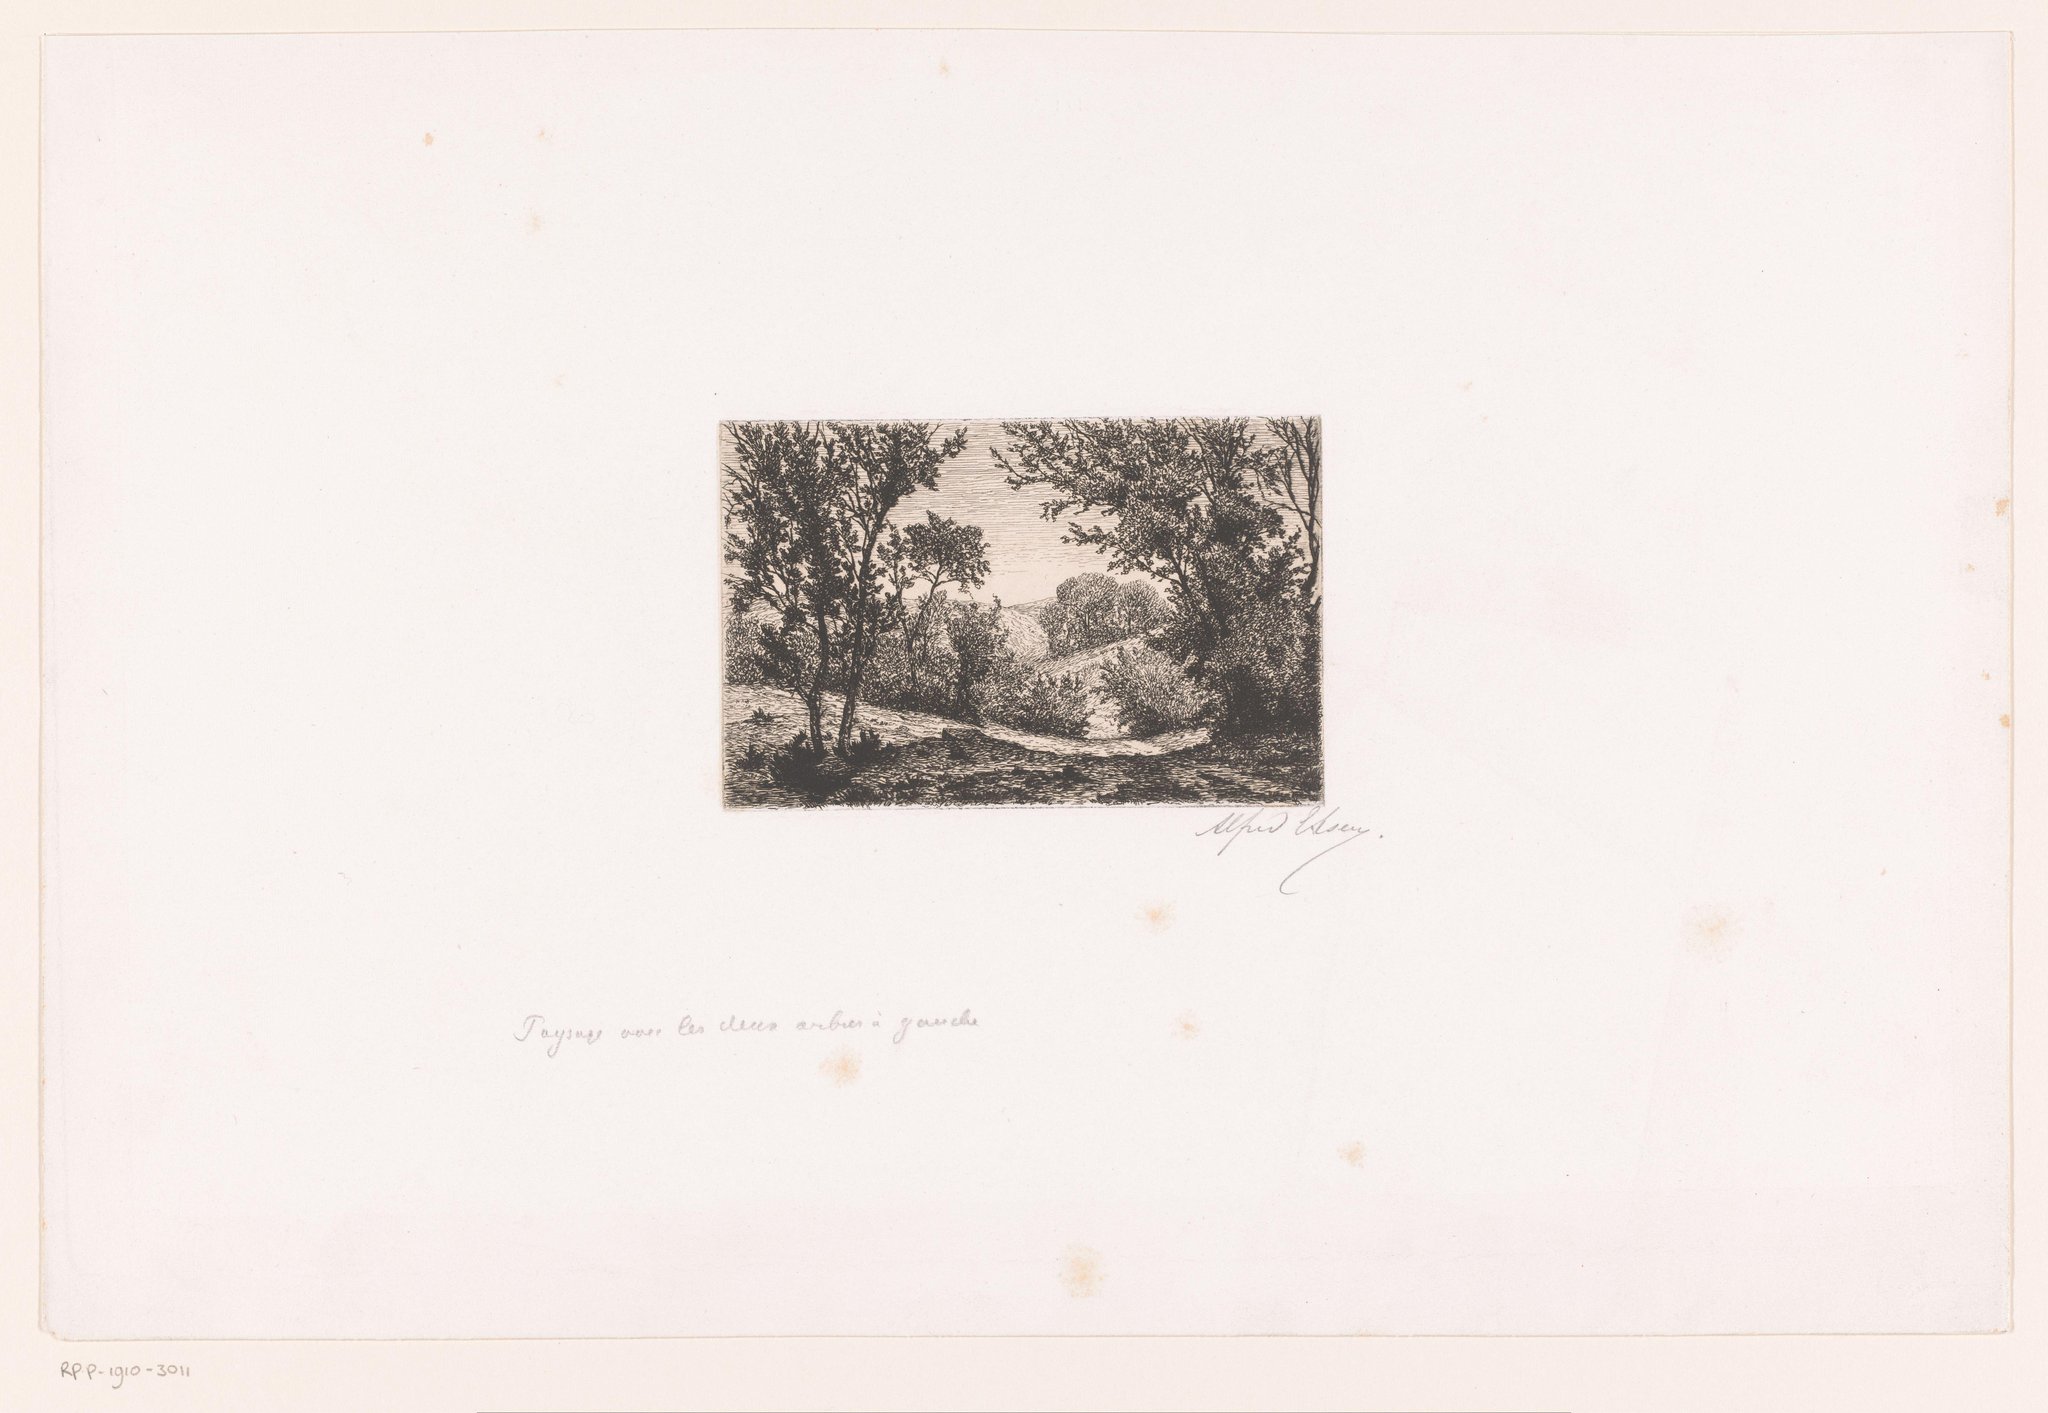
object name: print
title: Heuvellandschap met begroeiing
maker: alfred elsen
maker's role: painter, print maker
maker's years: 1850-1914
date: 1860-1910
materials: paper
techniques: etching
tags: low hill country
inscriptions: collector's mark: Lugt 2228